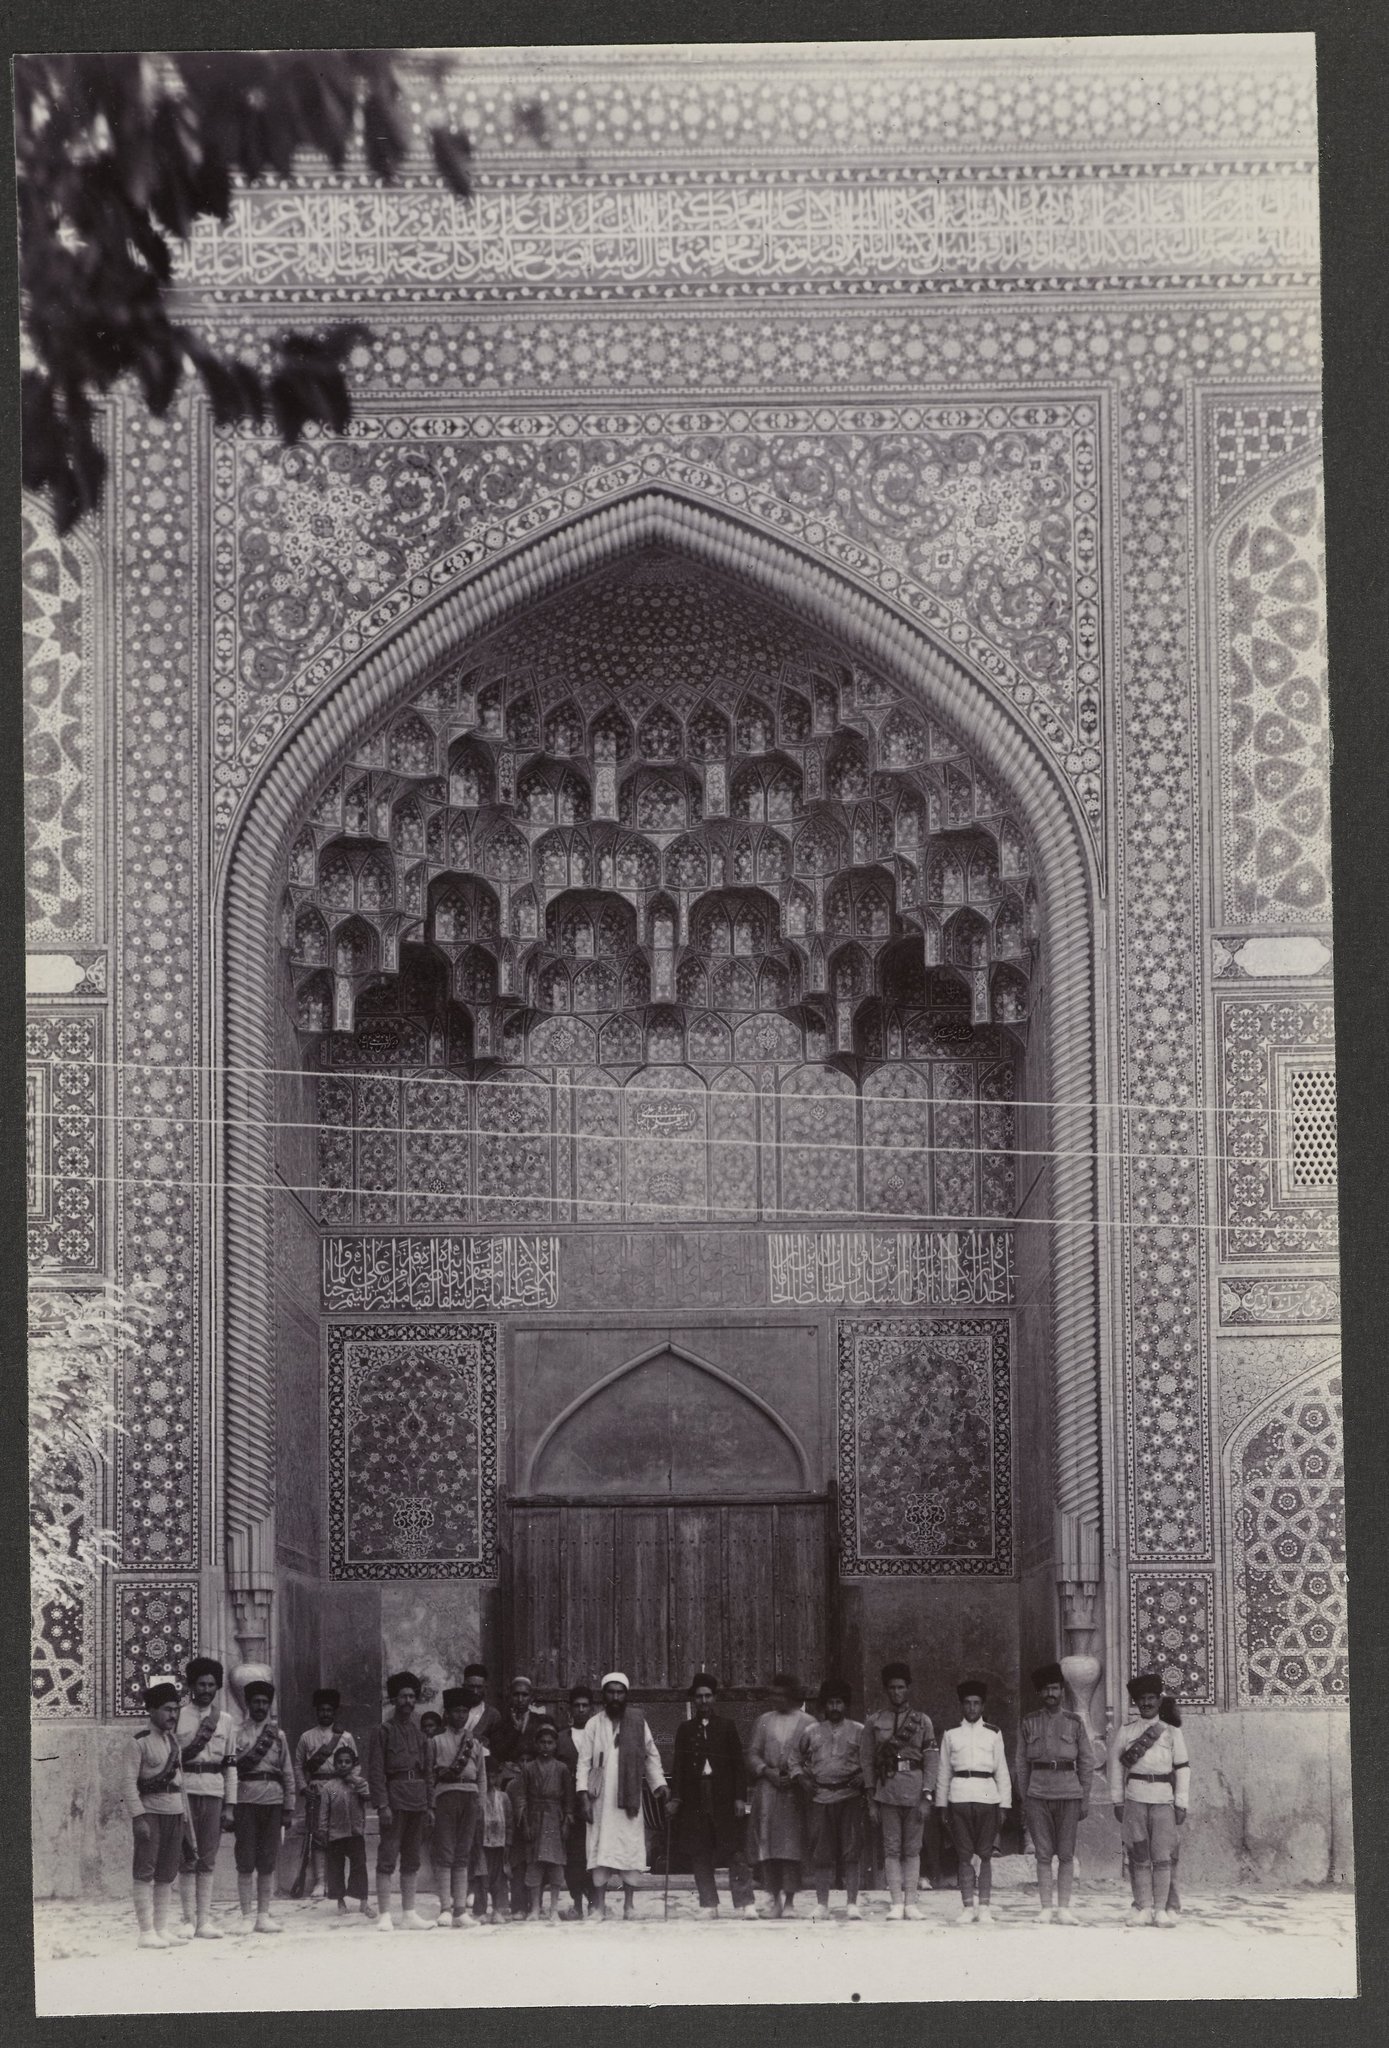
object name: photograph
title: Ingang van de Moskee van de Sjah (Masjed-e Shah) in Isfahan, Perzië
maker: a.g.a. van eelde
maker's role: engineer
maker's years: 1862-1950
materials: cardboard, paper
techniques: gelatin silver print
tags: isfahan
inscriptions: number: ‘49.’